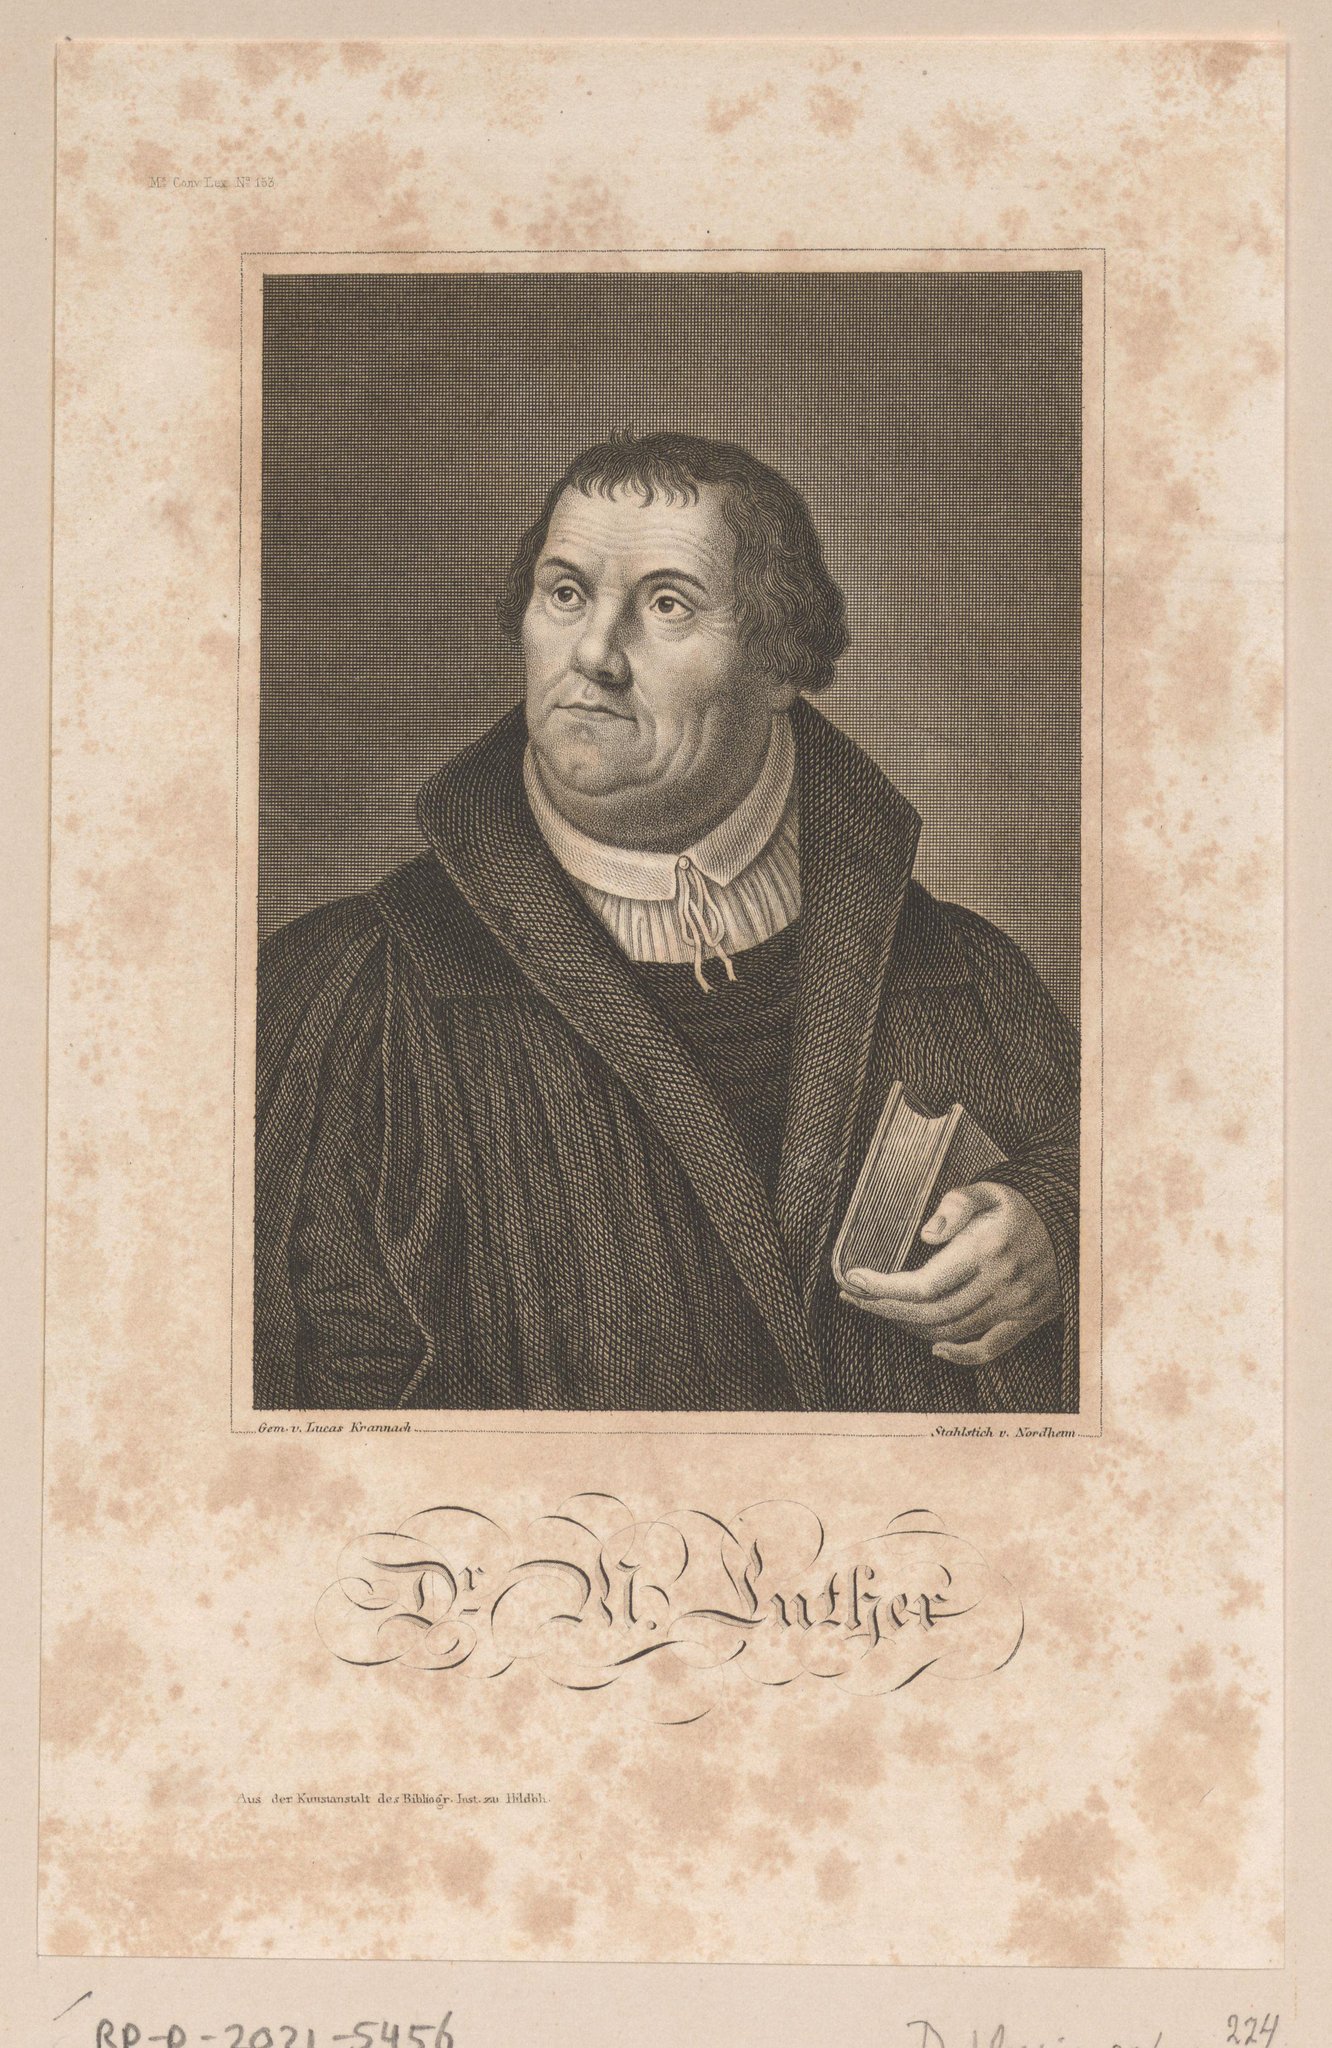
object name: book illustration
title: Portret van Martin Luther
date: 1839-1861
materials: paper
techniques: engraving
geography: hildburghausen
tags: priest, martin luther, theologian, historical persons, book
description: Prent waarschijnlijk uit: Meyer, Joseph. [Neues] Conversations-Lexikon für die gebildeten Stände. 52 dln. Hildburghausen: Bibliographisches Institut, 1839-1855. Of uit een latere editie.